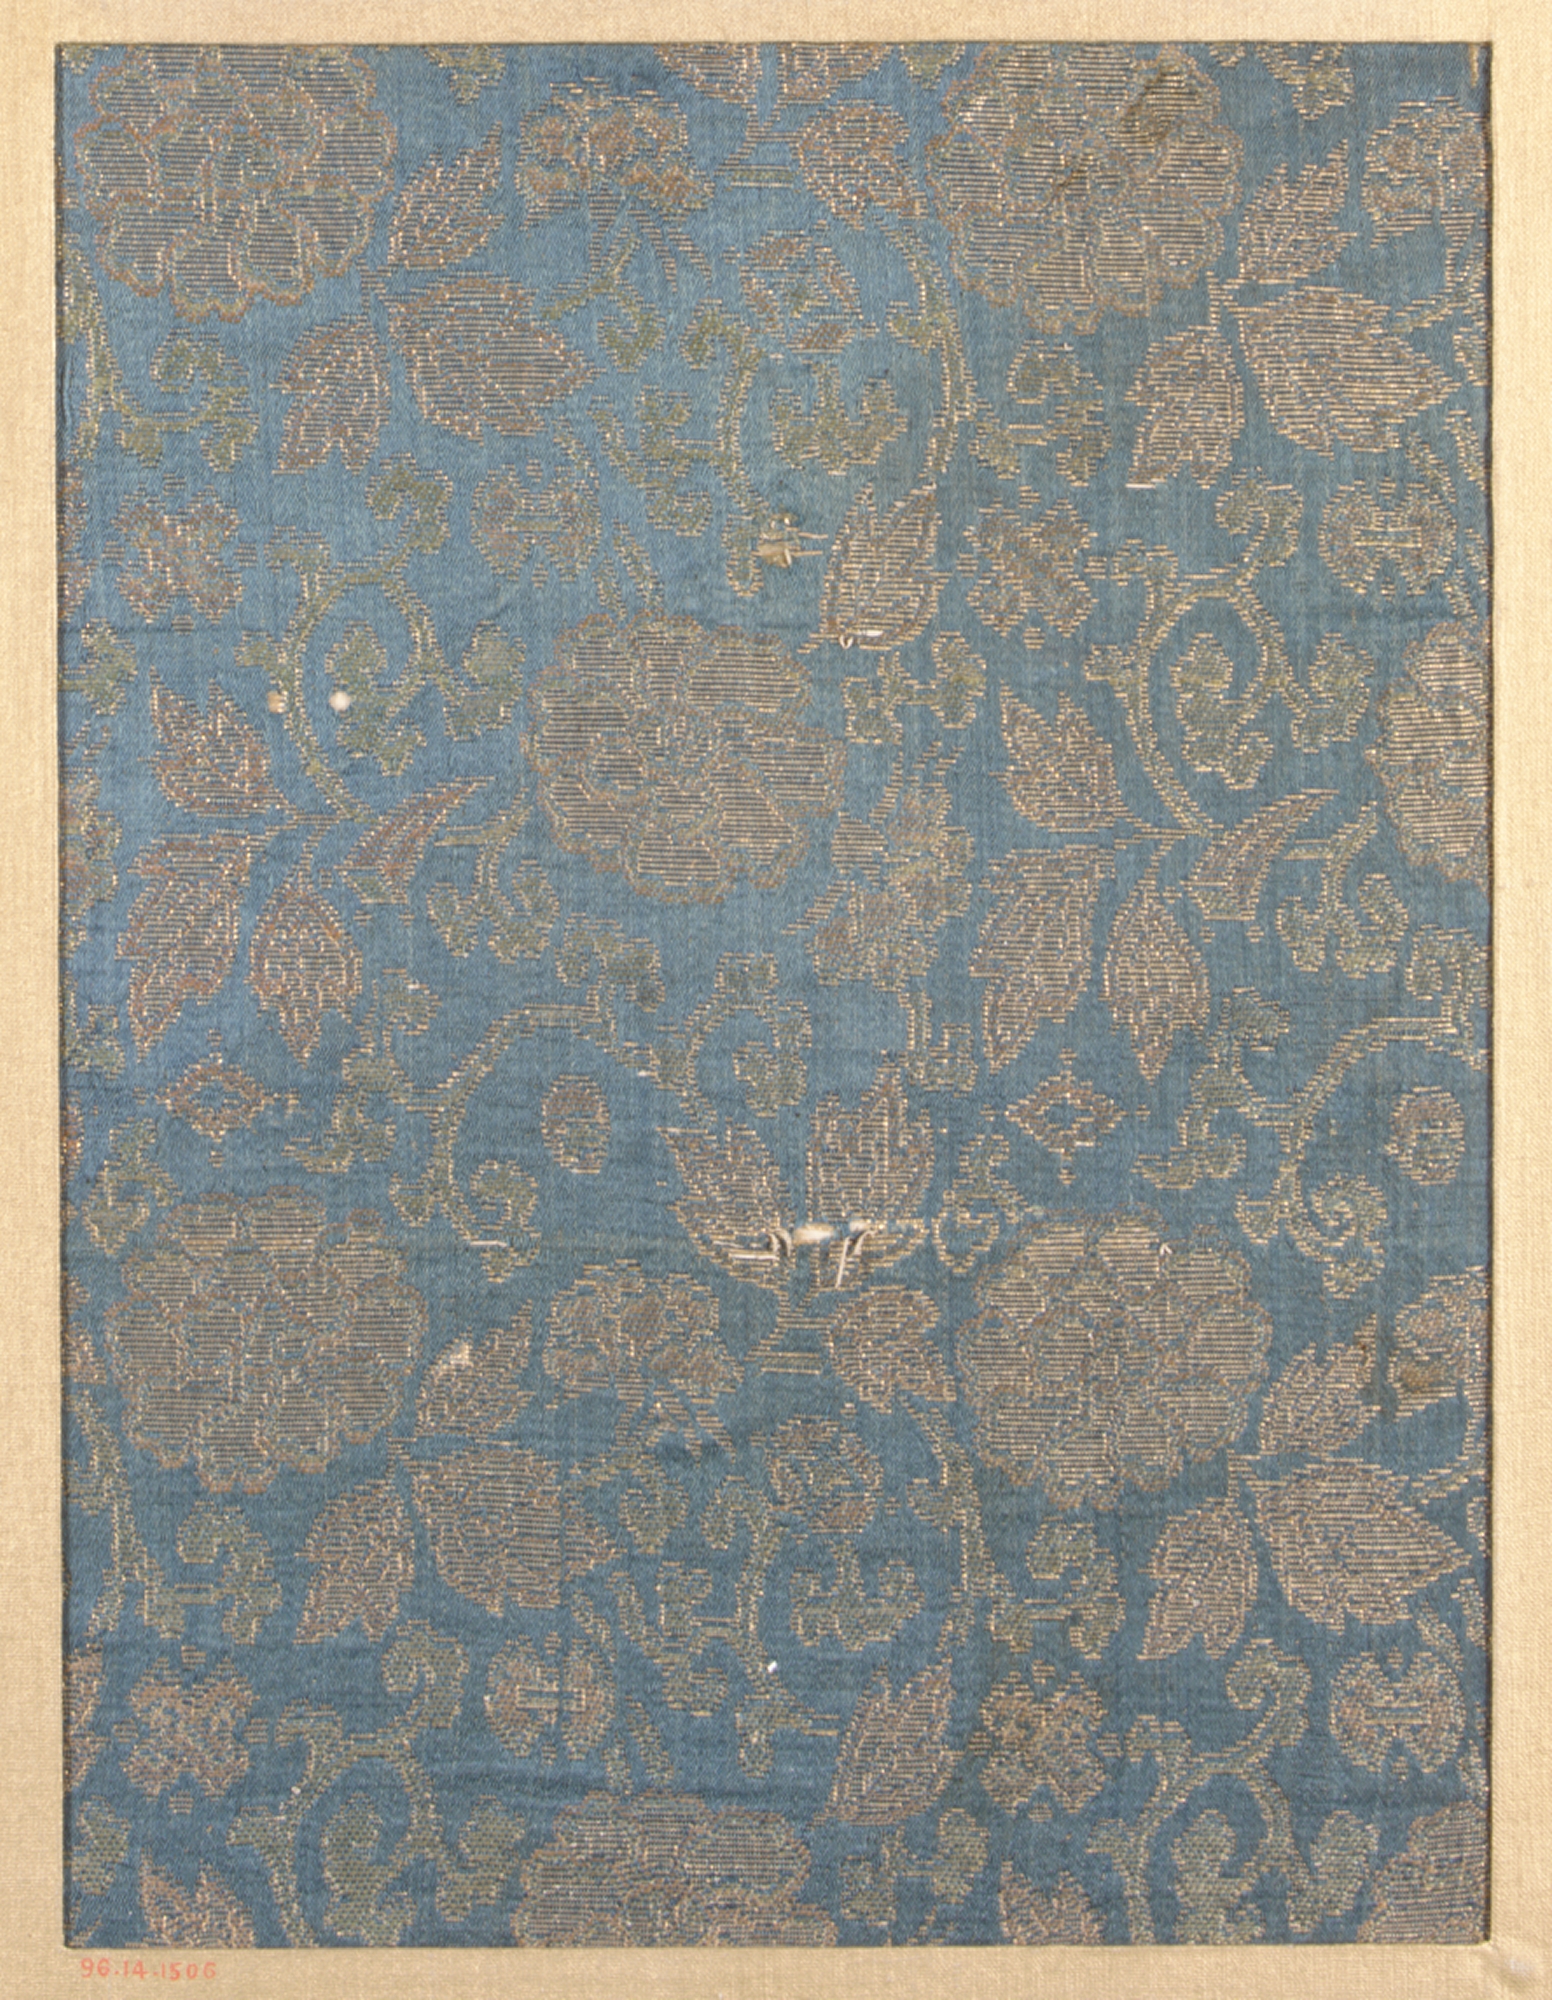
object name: piece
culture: japanese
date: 1701-1900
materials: silk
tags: leaves